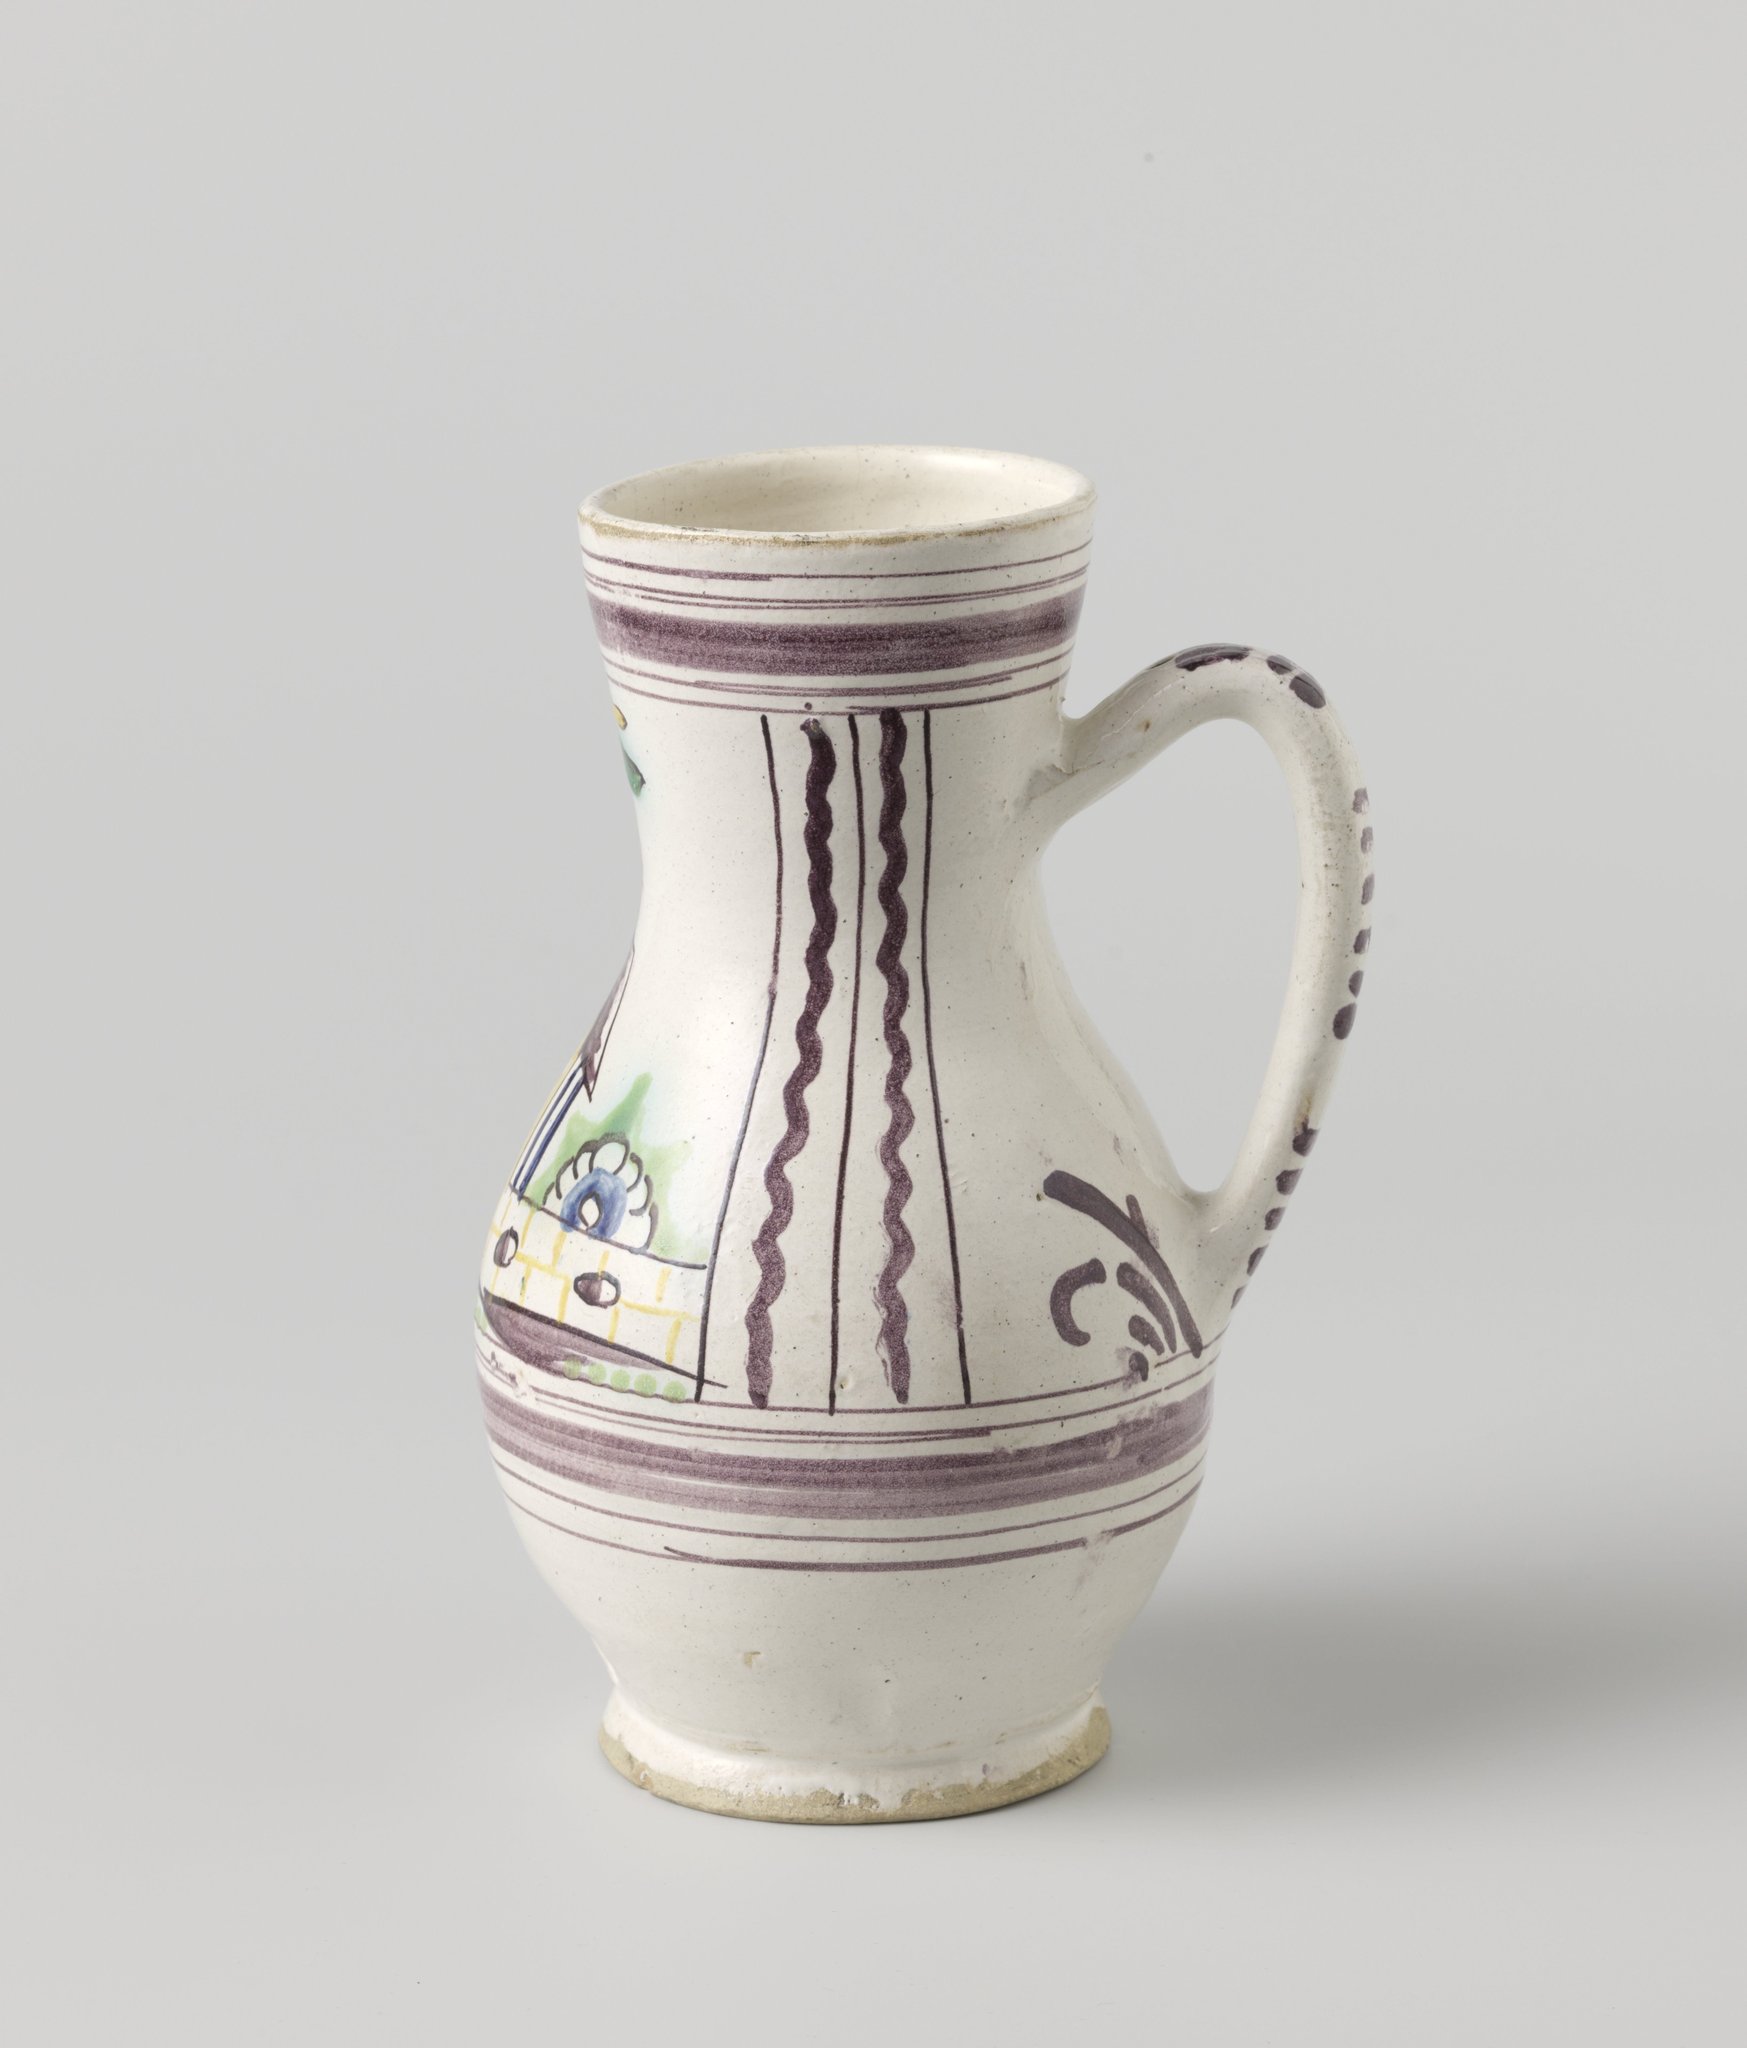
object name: ewer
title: Kan van veelkleurig beschilderde faience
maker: Anonymous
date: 1780-1840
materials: earthenware, glaze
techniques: painted, polychromy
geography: hungary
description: Slank omgekeerd balustervormige kan van veelkleurig beschilderde faience. De kan heeft een standring en een c-vormig oor. Op de kan is in de kleuren mangaan, geel, groen en blauw een huis geschilderd waar omheen verticale en horizontale lijnen.